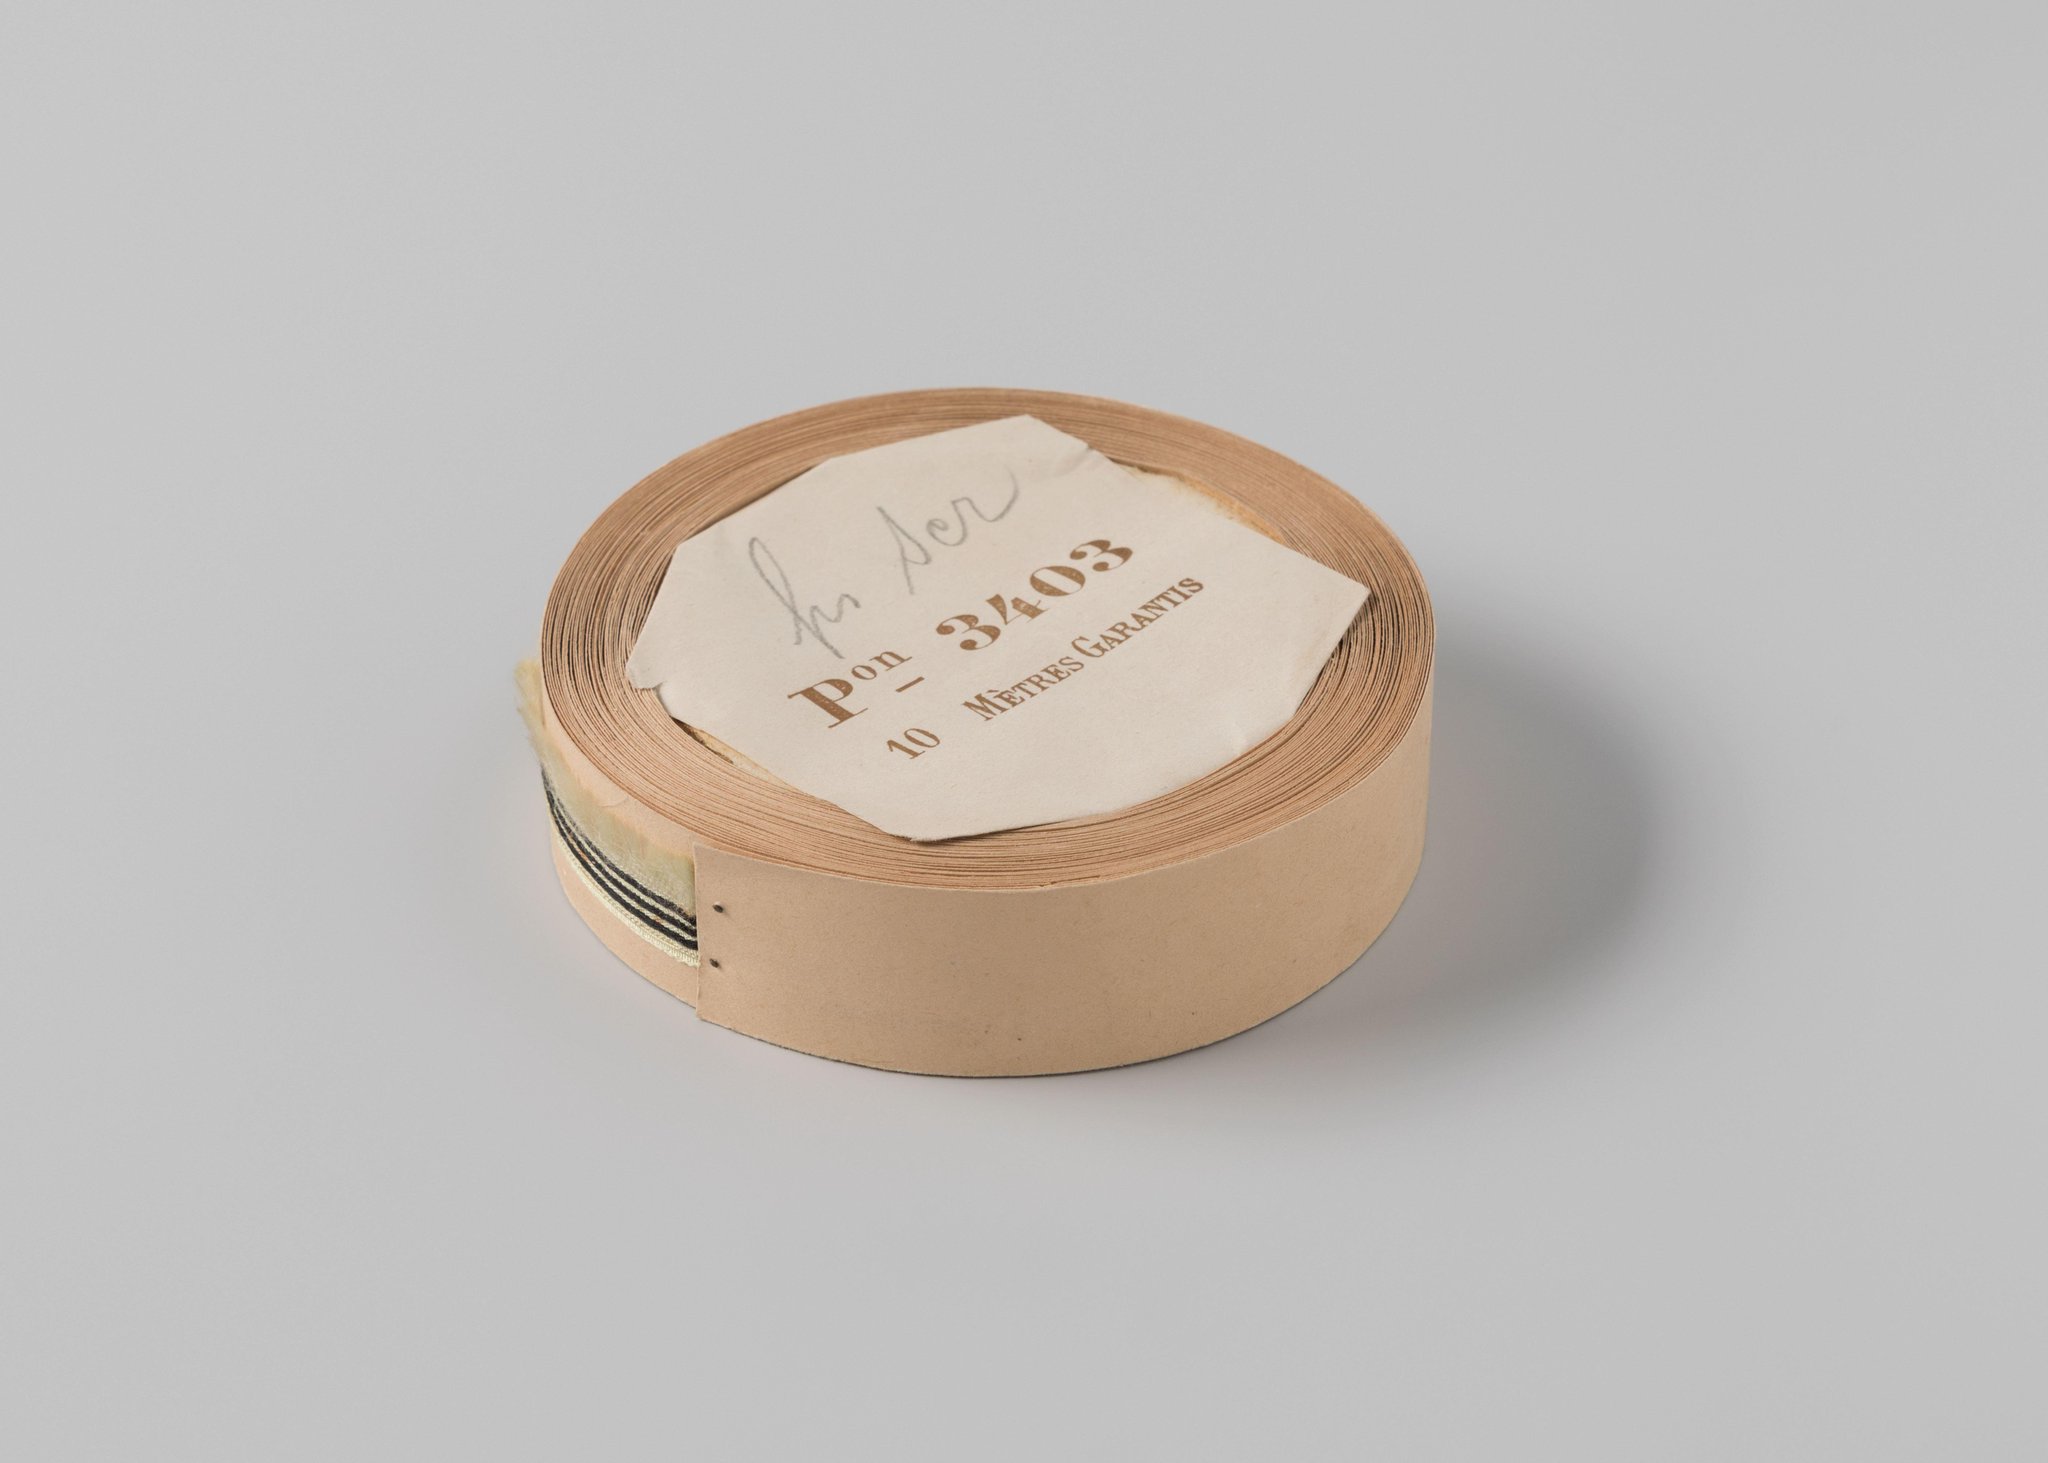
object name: ribbon material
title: Rol met lichtgroen lint met één gerafelde zijde en drie zwarte horizontale strepen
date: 1930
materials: cardboard, paper, textile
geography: france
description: Rol met lichtgroen lint met één gerafelde zijde en drie zwarte horizontale strepen.